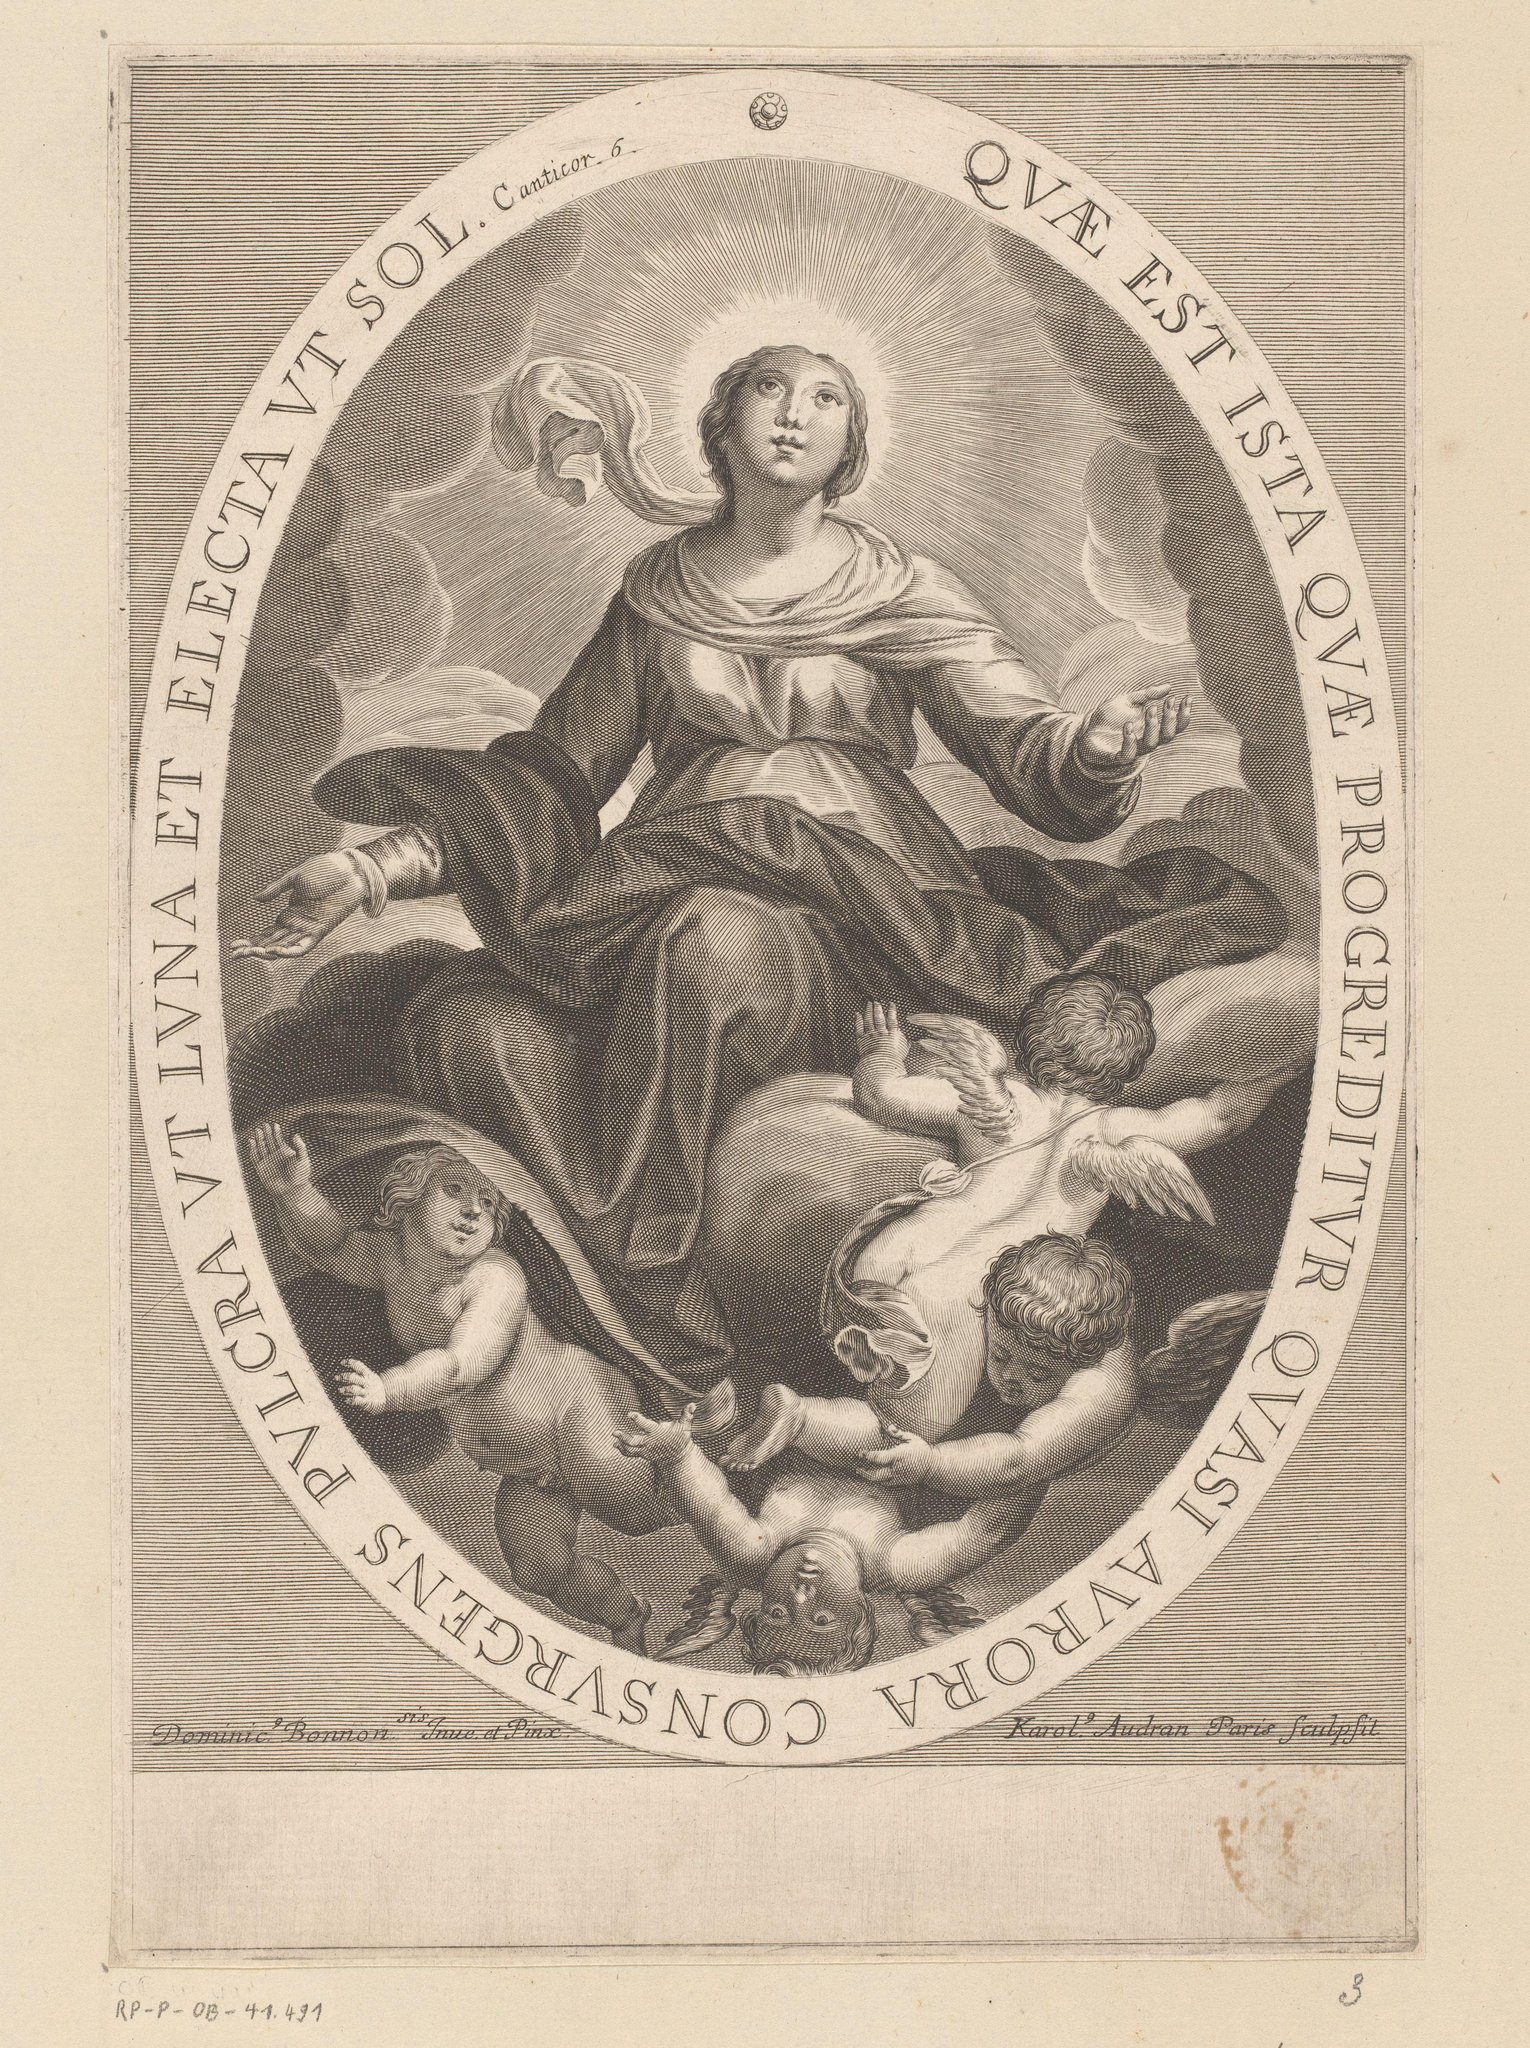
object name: print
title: Hemelvaart van Maria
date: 1604-1674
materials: paper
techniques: engraving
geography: paris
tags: the assumption of mary ('assumptio corporis'): she is borne into heaven by angels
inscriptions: collector's mark: Lugt 240